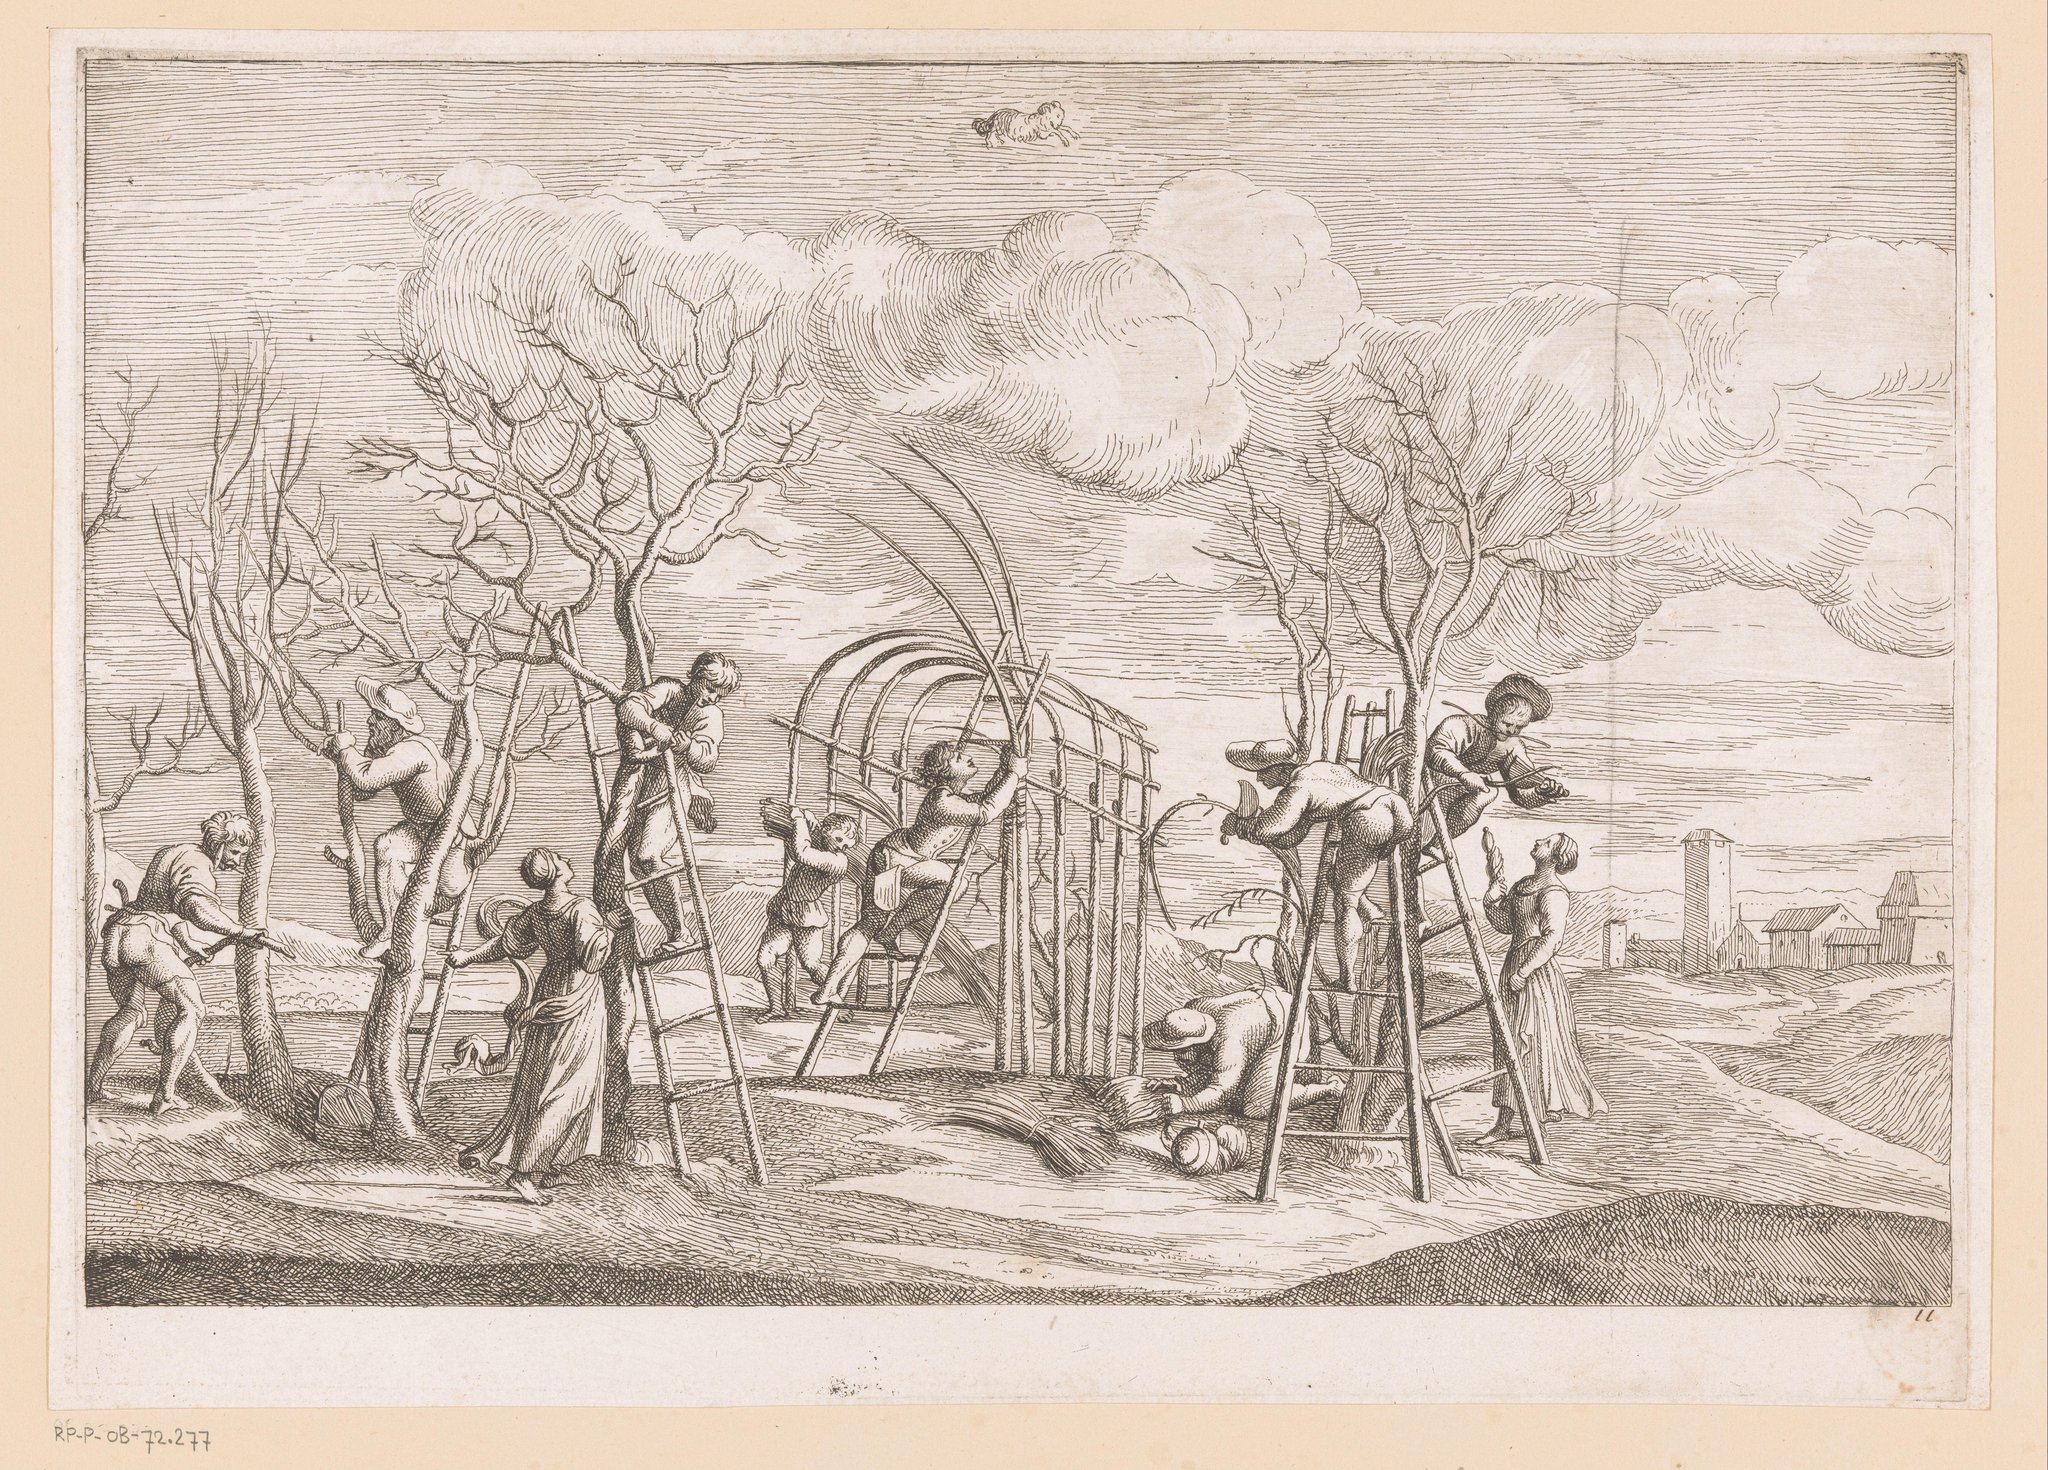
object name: print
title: Prenten naar tekeningen uit het kabinet Jabach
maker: jean pesne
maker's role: print maker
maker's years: 1623-1700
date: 1666-1695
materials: paper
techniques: etching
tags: vineyard, aries (zodical sign of march)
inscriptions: number: ‘11’, collector's mark: Lugt 240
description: Prent maakt deel uit van een serie van 283 prenten, ongenummerde staat.